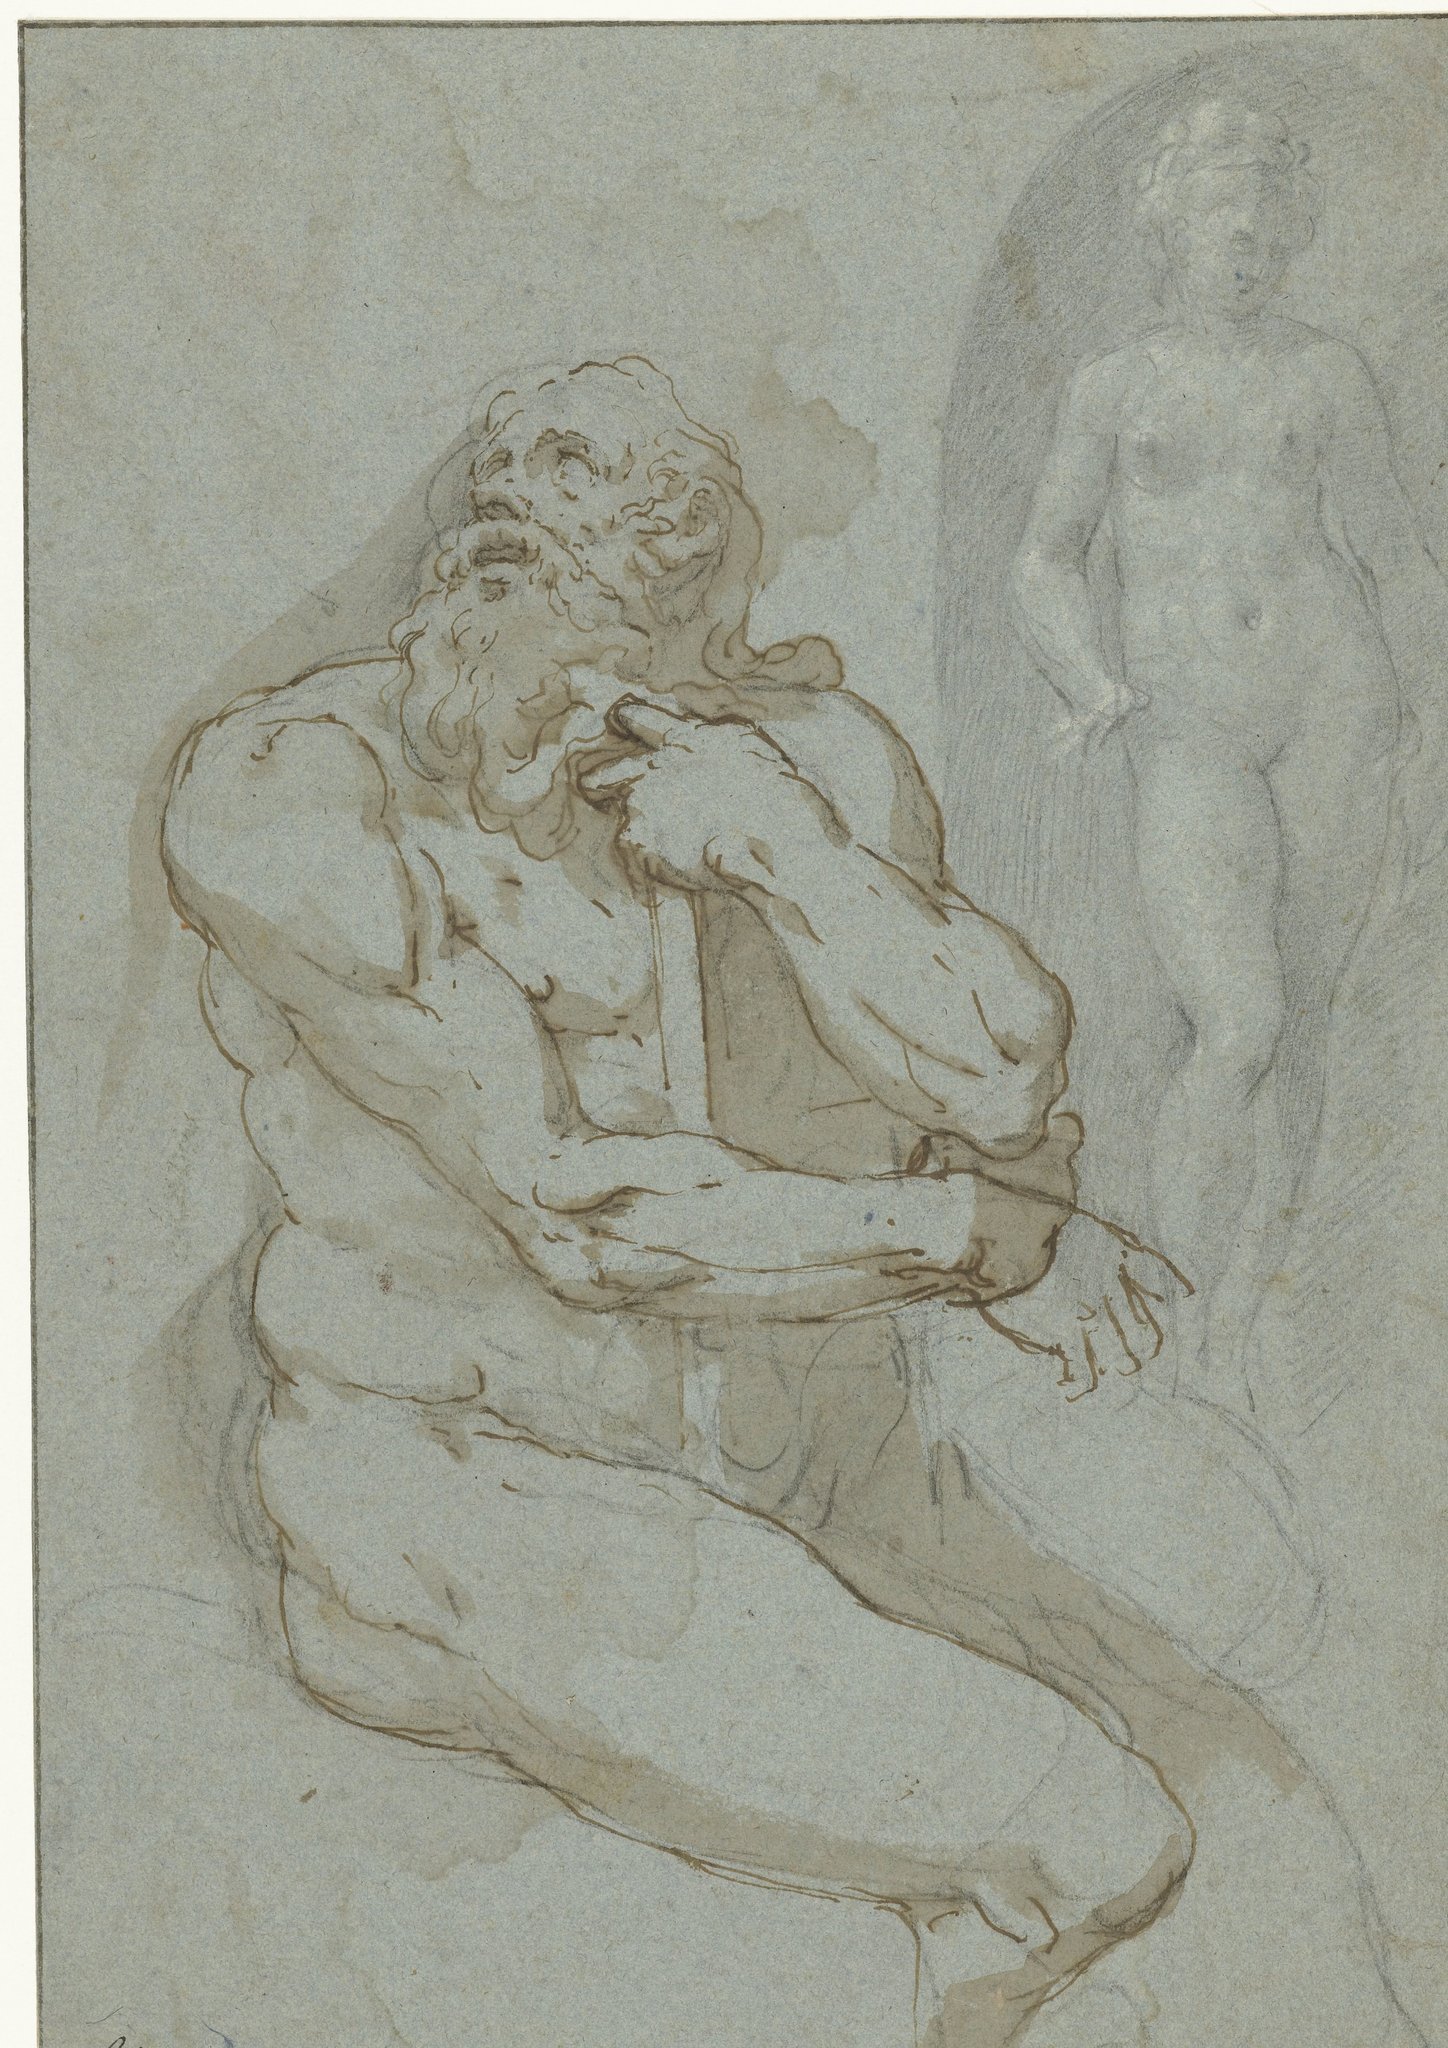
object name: drawing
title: Neptune before a niche with Amphitrite (?)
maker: francesco salviati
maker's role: draughtsman, painter, print maker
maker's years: 1510-1563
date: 1520-1563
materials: chalk, ink, paper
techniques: brush, pen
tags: (story of) neptune (poseidon)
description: For Neptune’s resting arm, the painter Salviati was here inspired by the right arm of Michelangelo’s statue Night. An illustration of this sculpture on Lorenzo de’ Medici’s tomb in Florence is also on view in this gallery. Other sketches also show just how closely Salviati studied Michelangelo’s sculptures. In this drawing he experimented with the pose of Neptune’s hand.